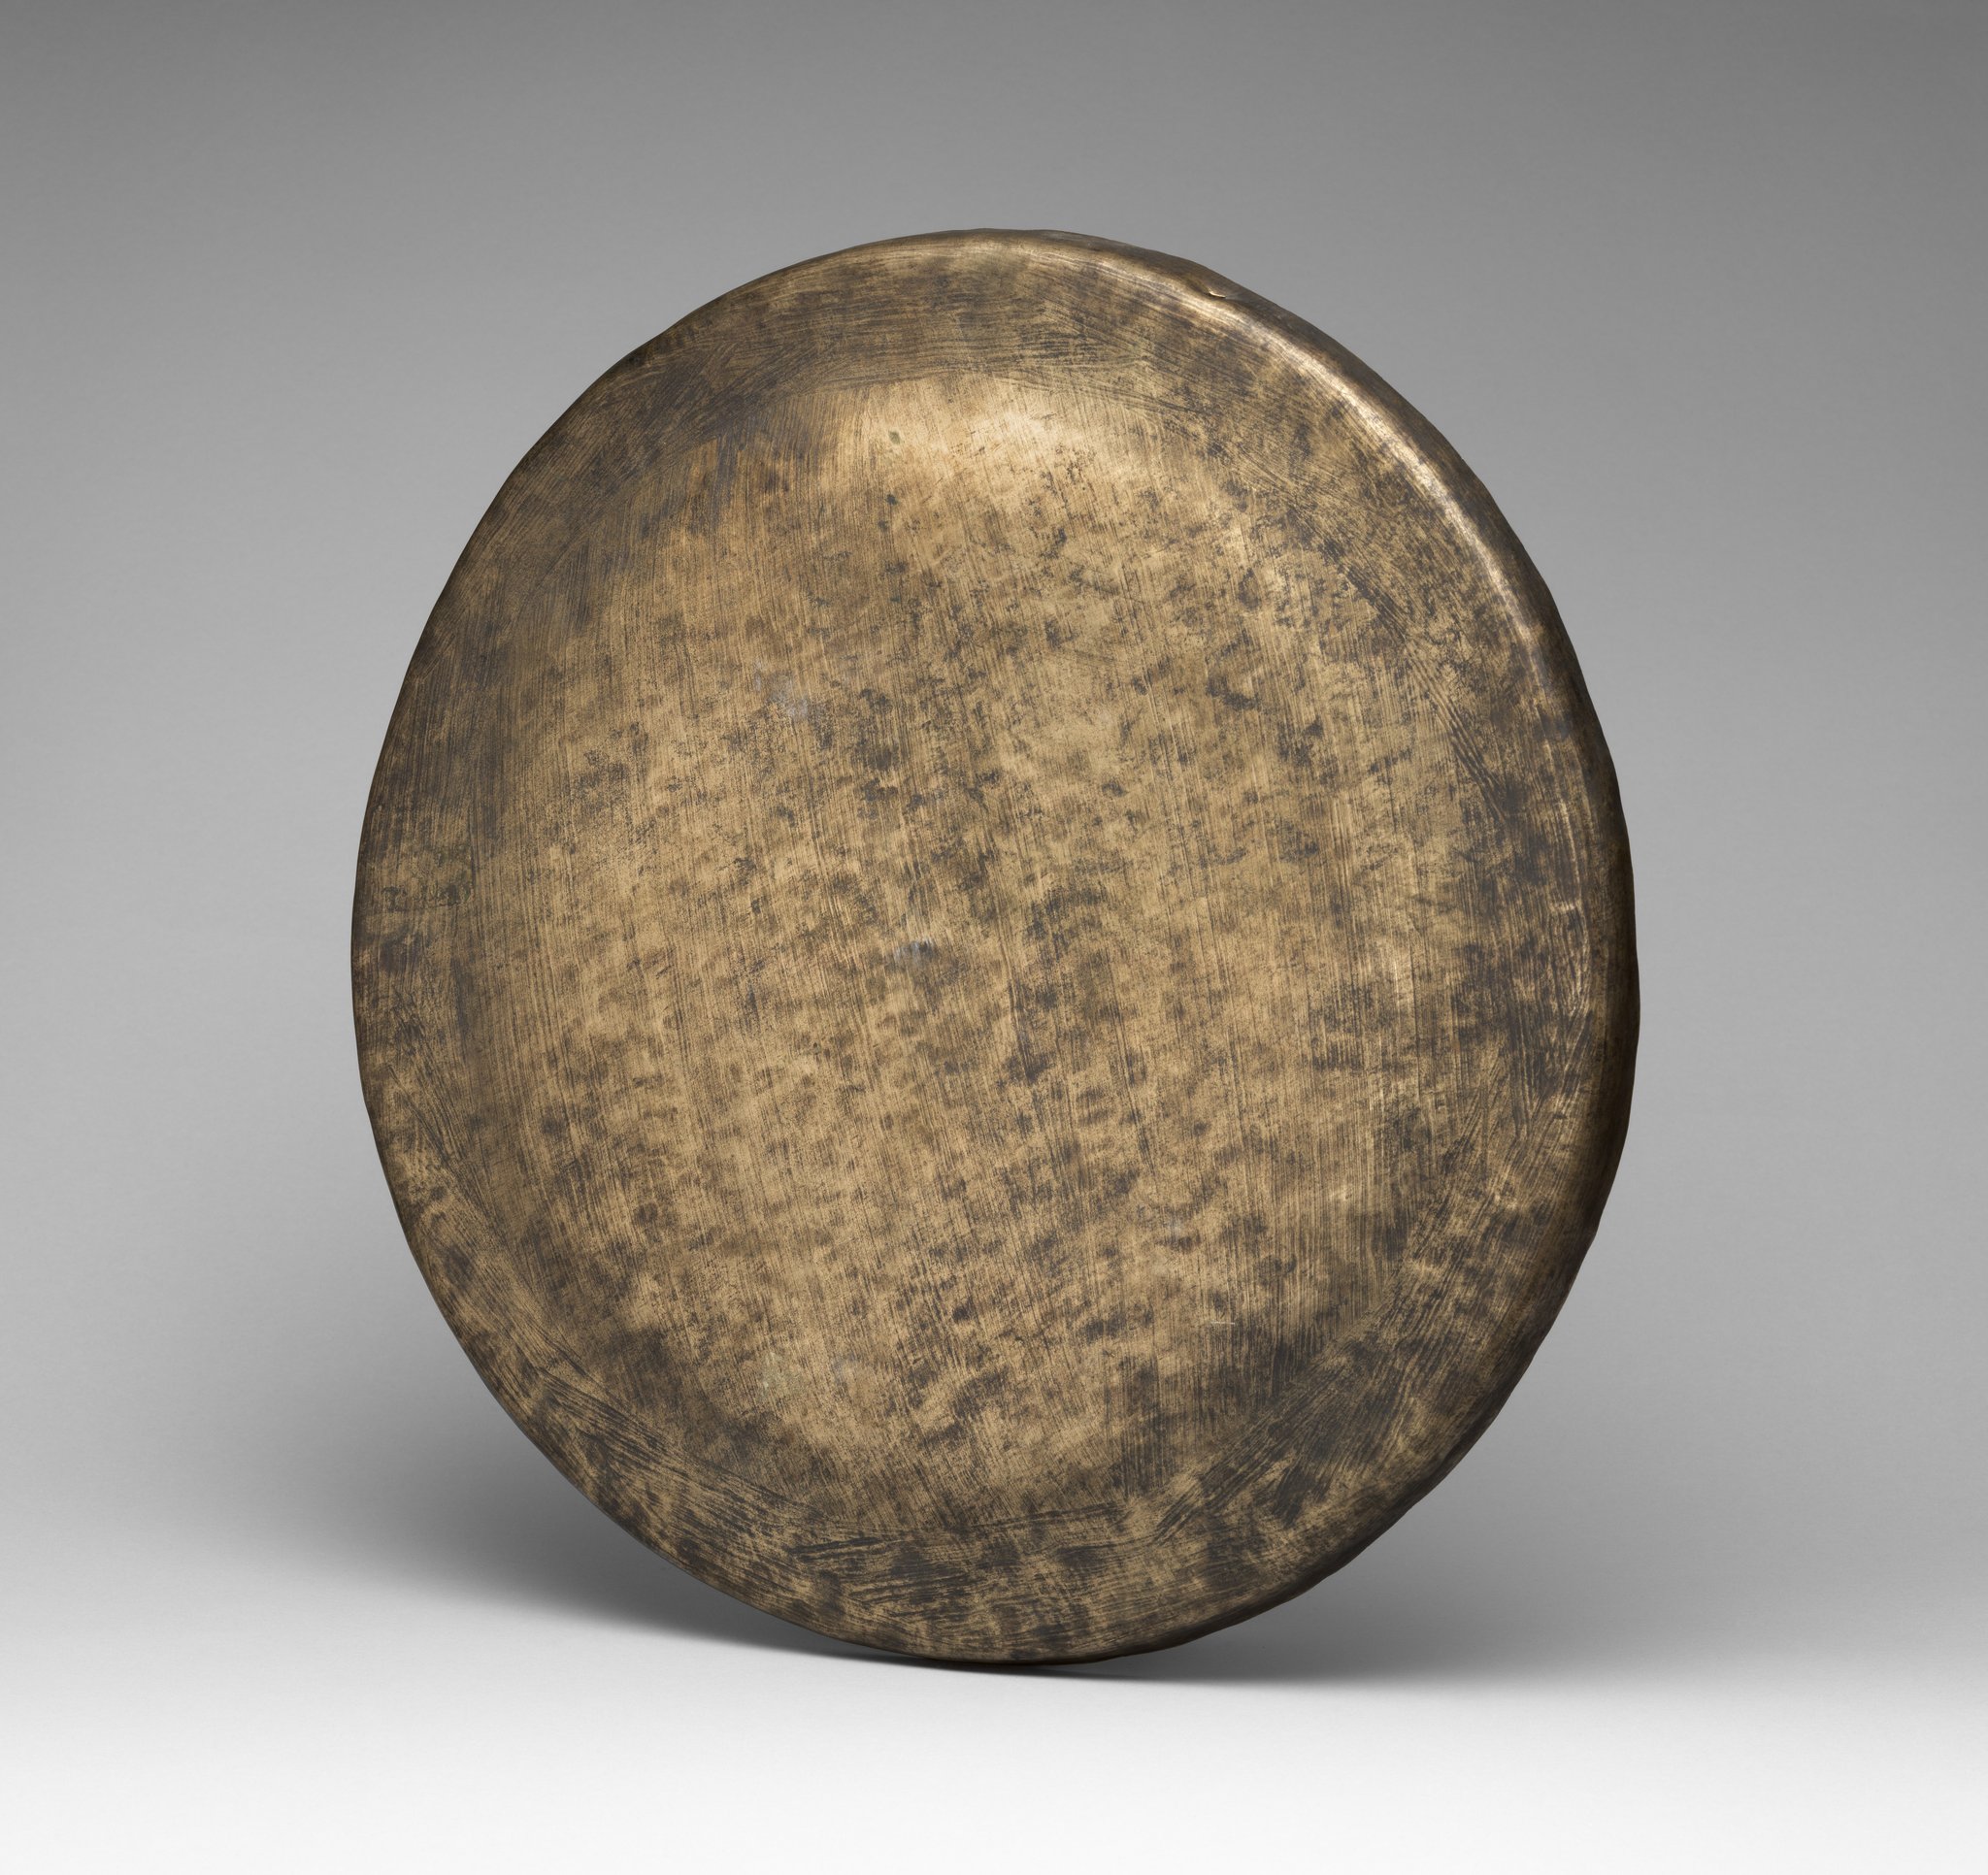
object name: luo gong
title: Luo (锣 or 鑼 )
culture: chinese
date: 1801-1900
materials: leather, metal, wood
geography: china